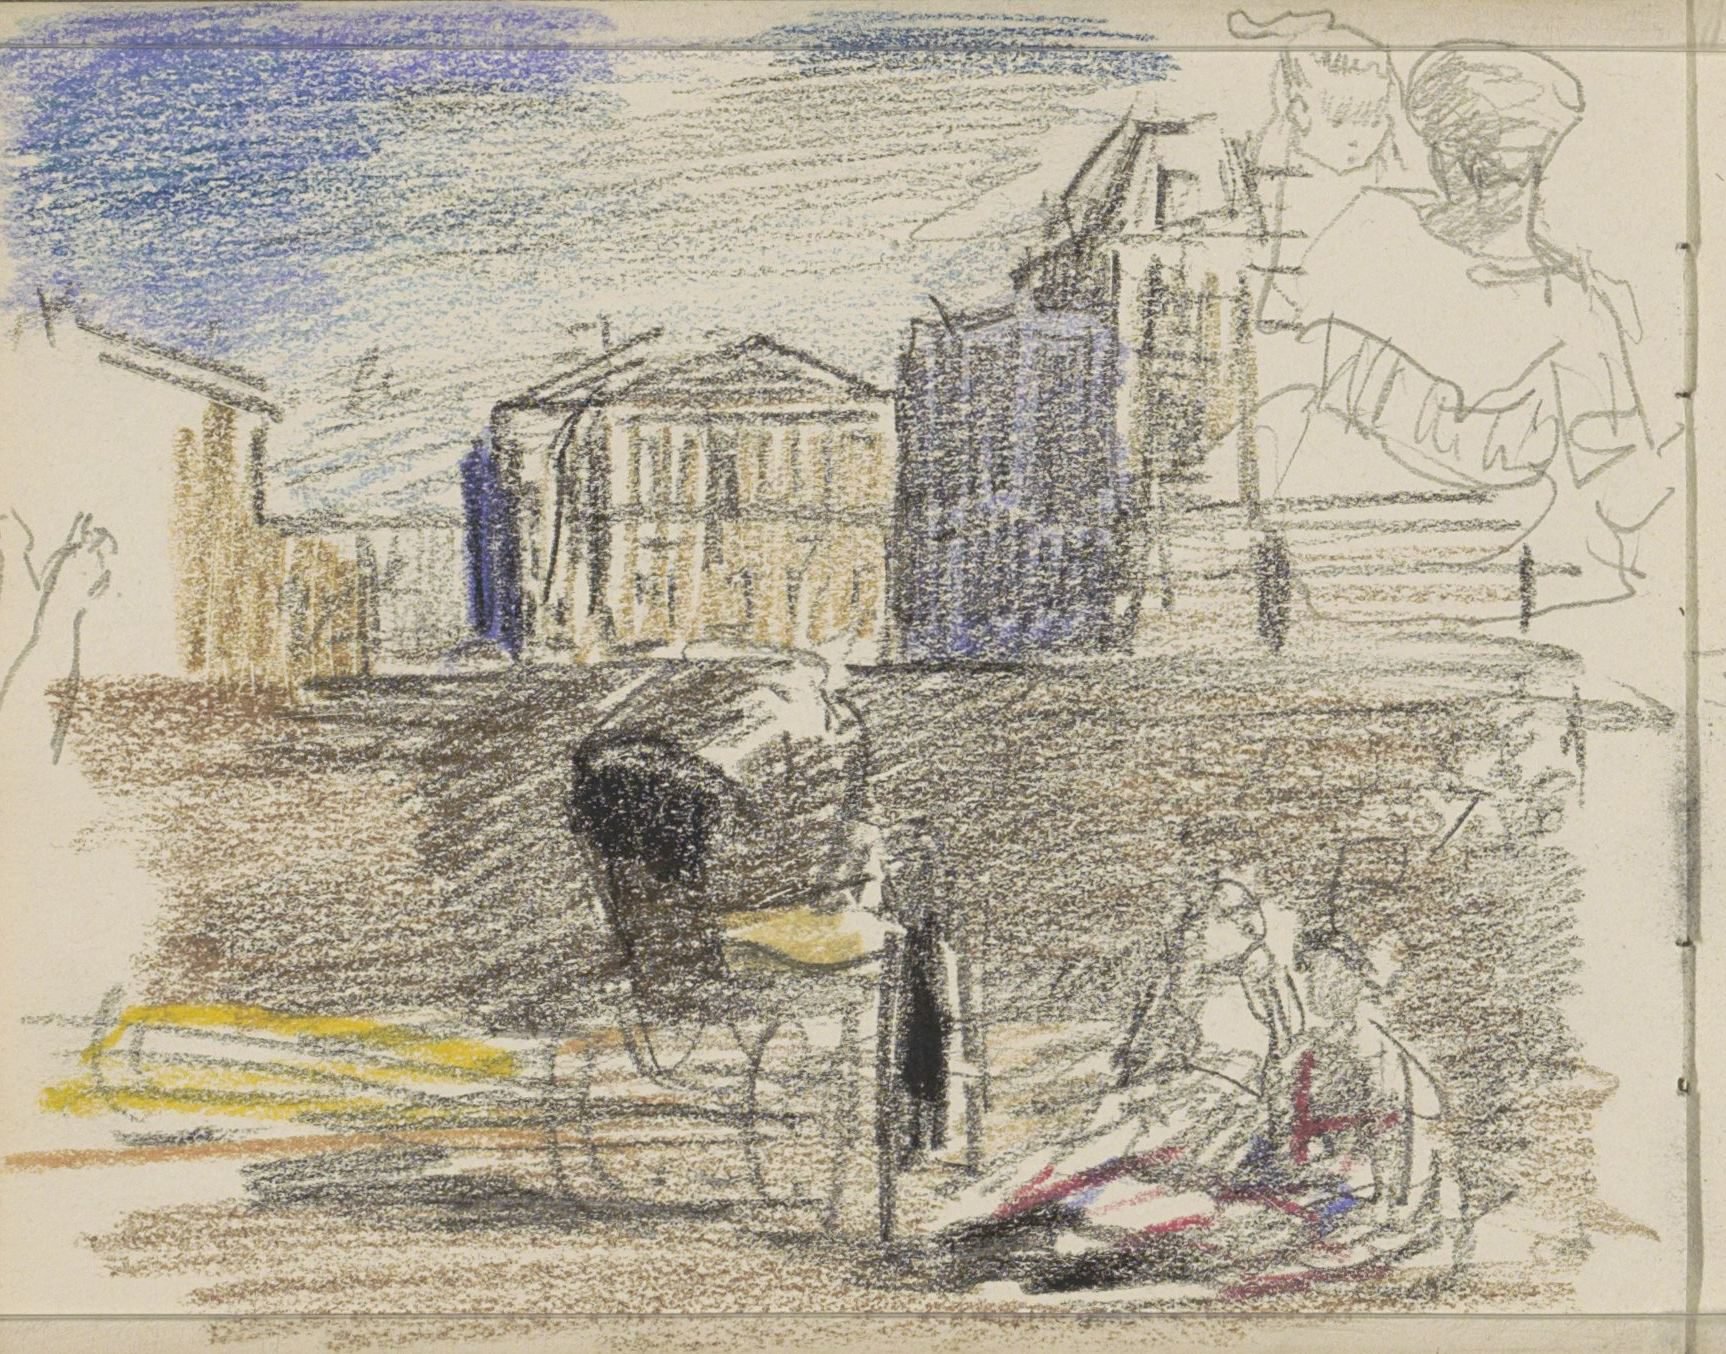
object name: sketchbook leaf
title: Zittende figuren bij een kinderwagen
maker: johan antonie de jonge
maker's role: draughtsman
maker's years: 1864-1927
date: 1881-1927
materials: chalk, paper, pencil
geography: south holland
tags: beach (as place of recreation), baby-carriage, pram, perambulator, urban housing, sitting figure - aa - female human figure, mother and child(ren), woman and child(ren) (family group)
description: Vooraan zitten twee figuren, mogelijk op het strand, bij een kinderwagen. Achter hen een muur en gebouwen. Rechtsboven een vrouw met een kind. Blad 4 verso uit een schetsboek met 29 bladen.